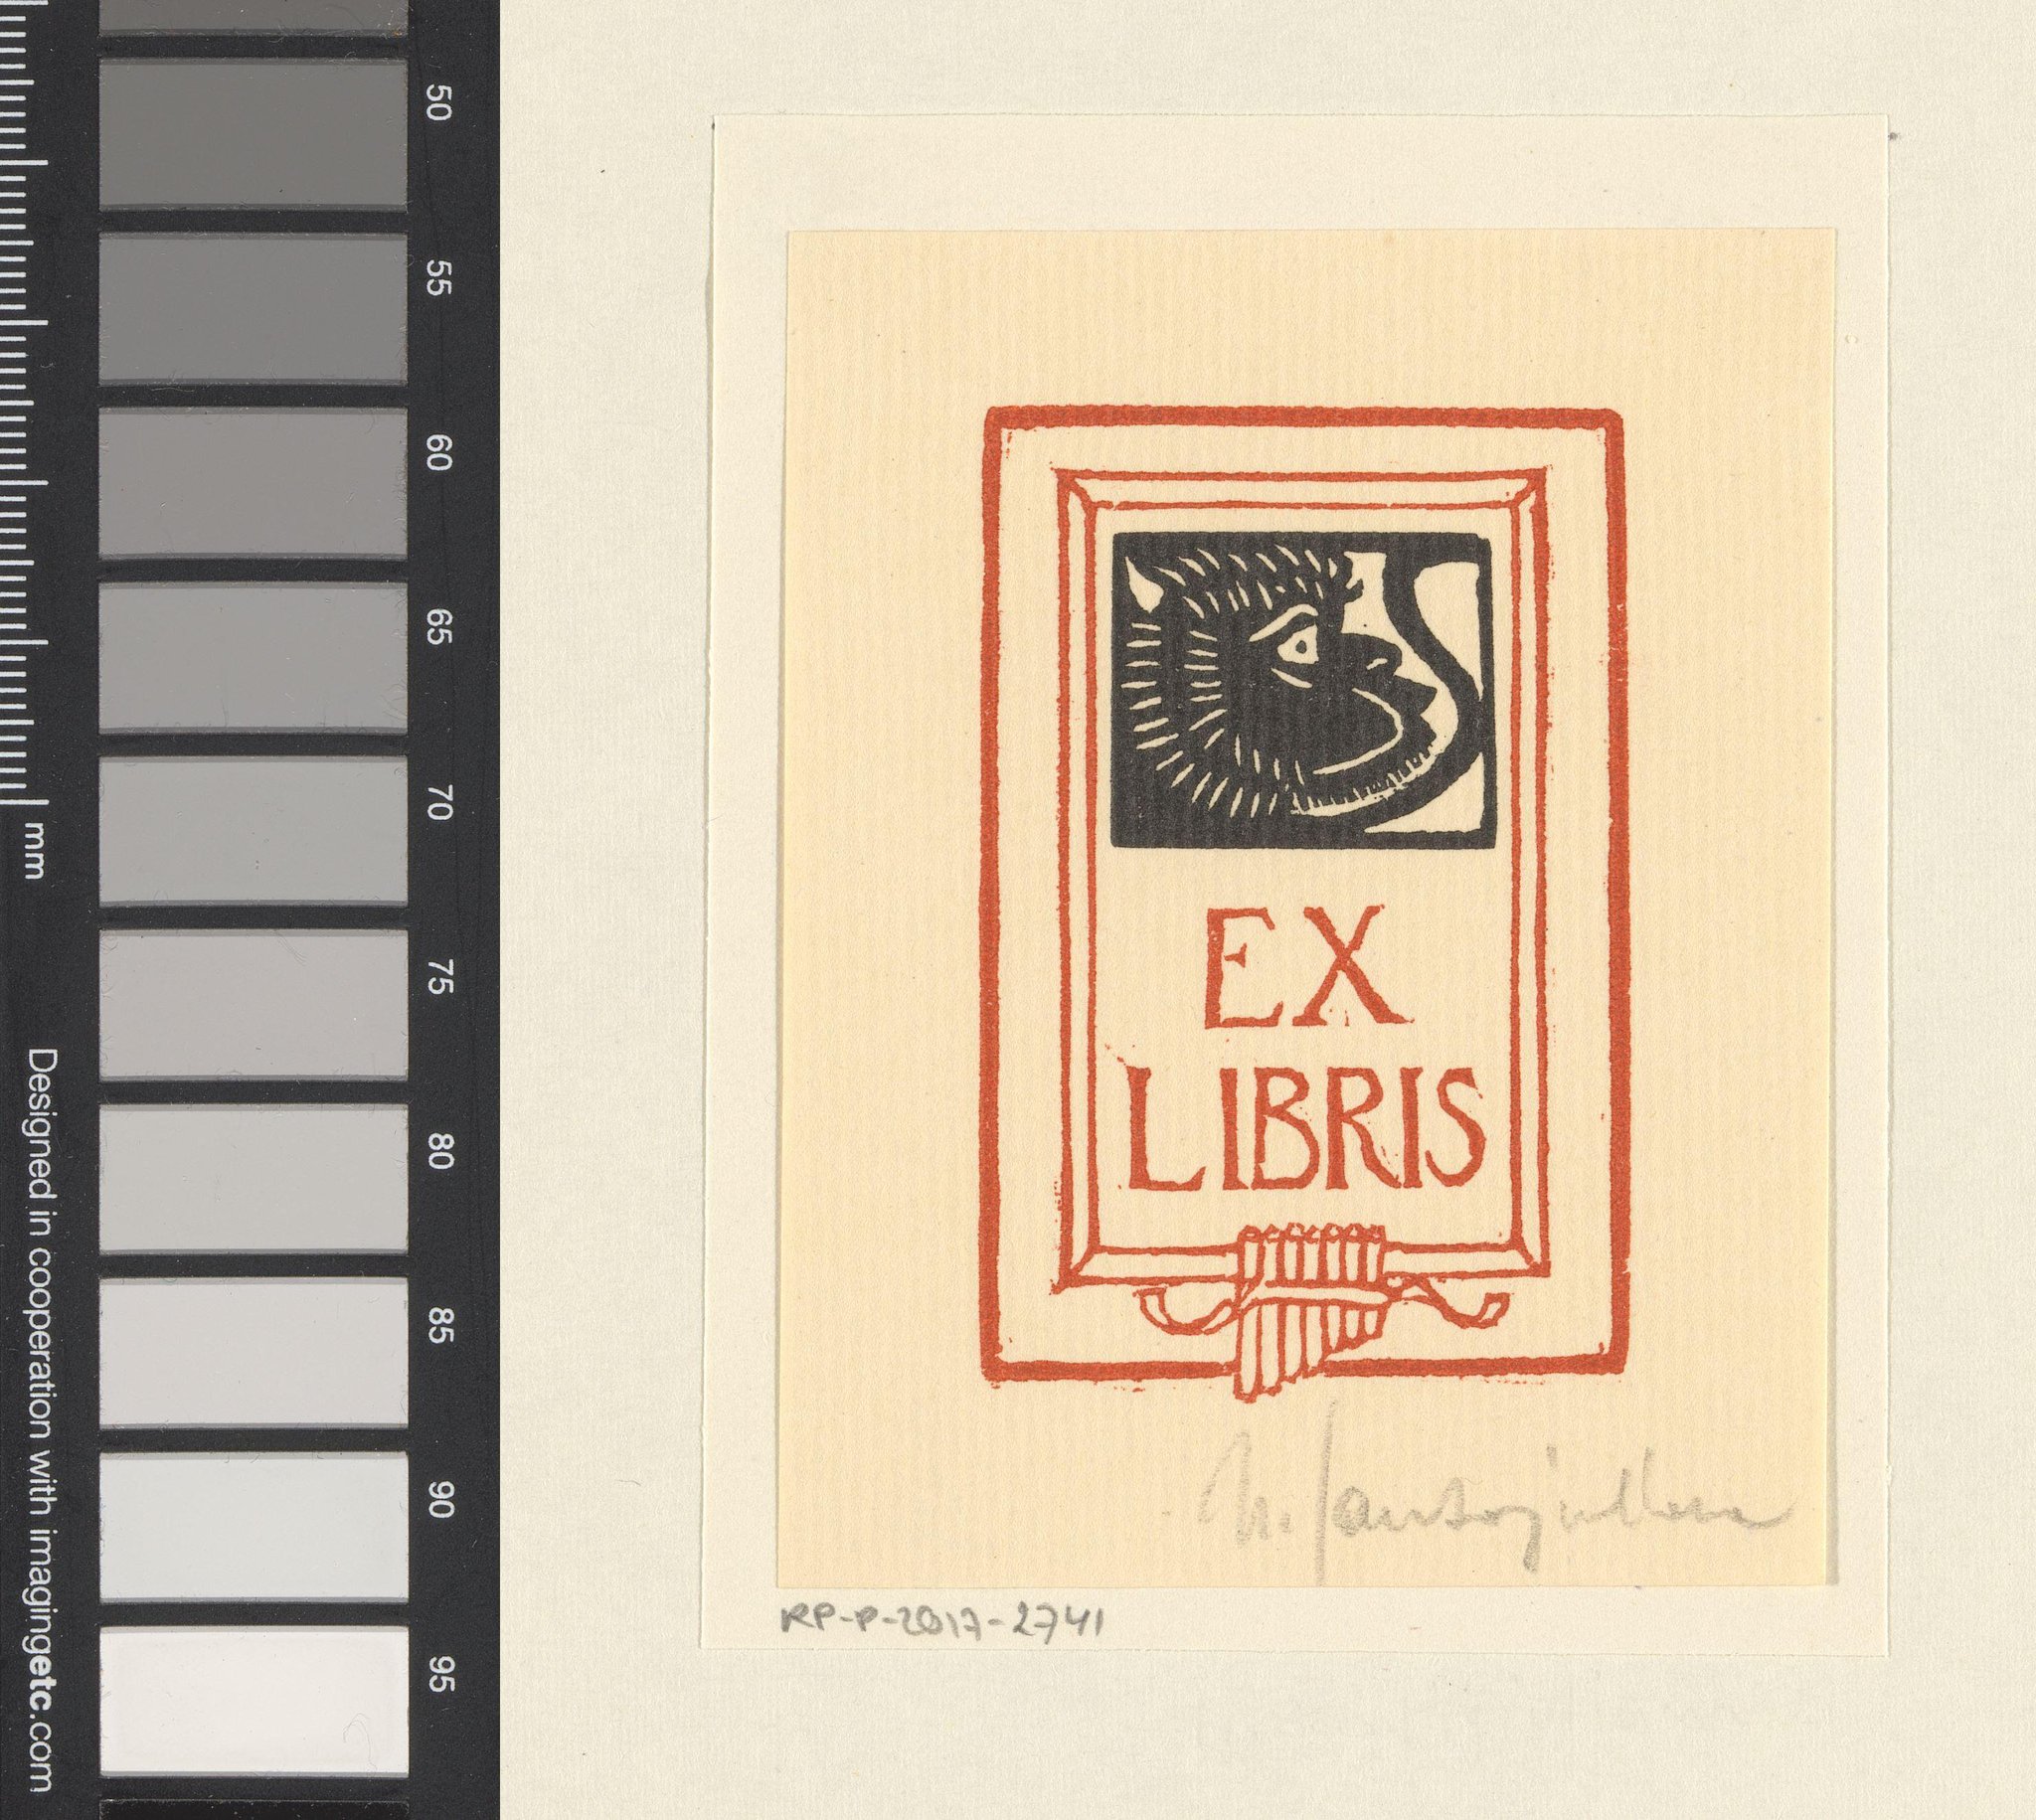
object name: bookplate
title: Ex libris van onbekend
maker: n. santigiuliana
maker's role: print maker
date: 1900-1999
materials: paper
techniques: woodcut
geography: italy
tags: panpipes, devil(s) and demons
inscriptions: signature and date: ‘N. Santigiuliana’